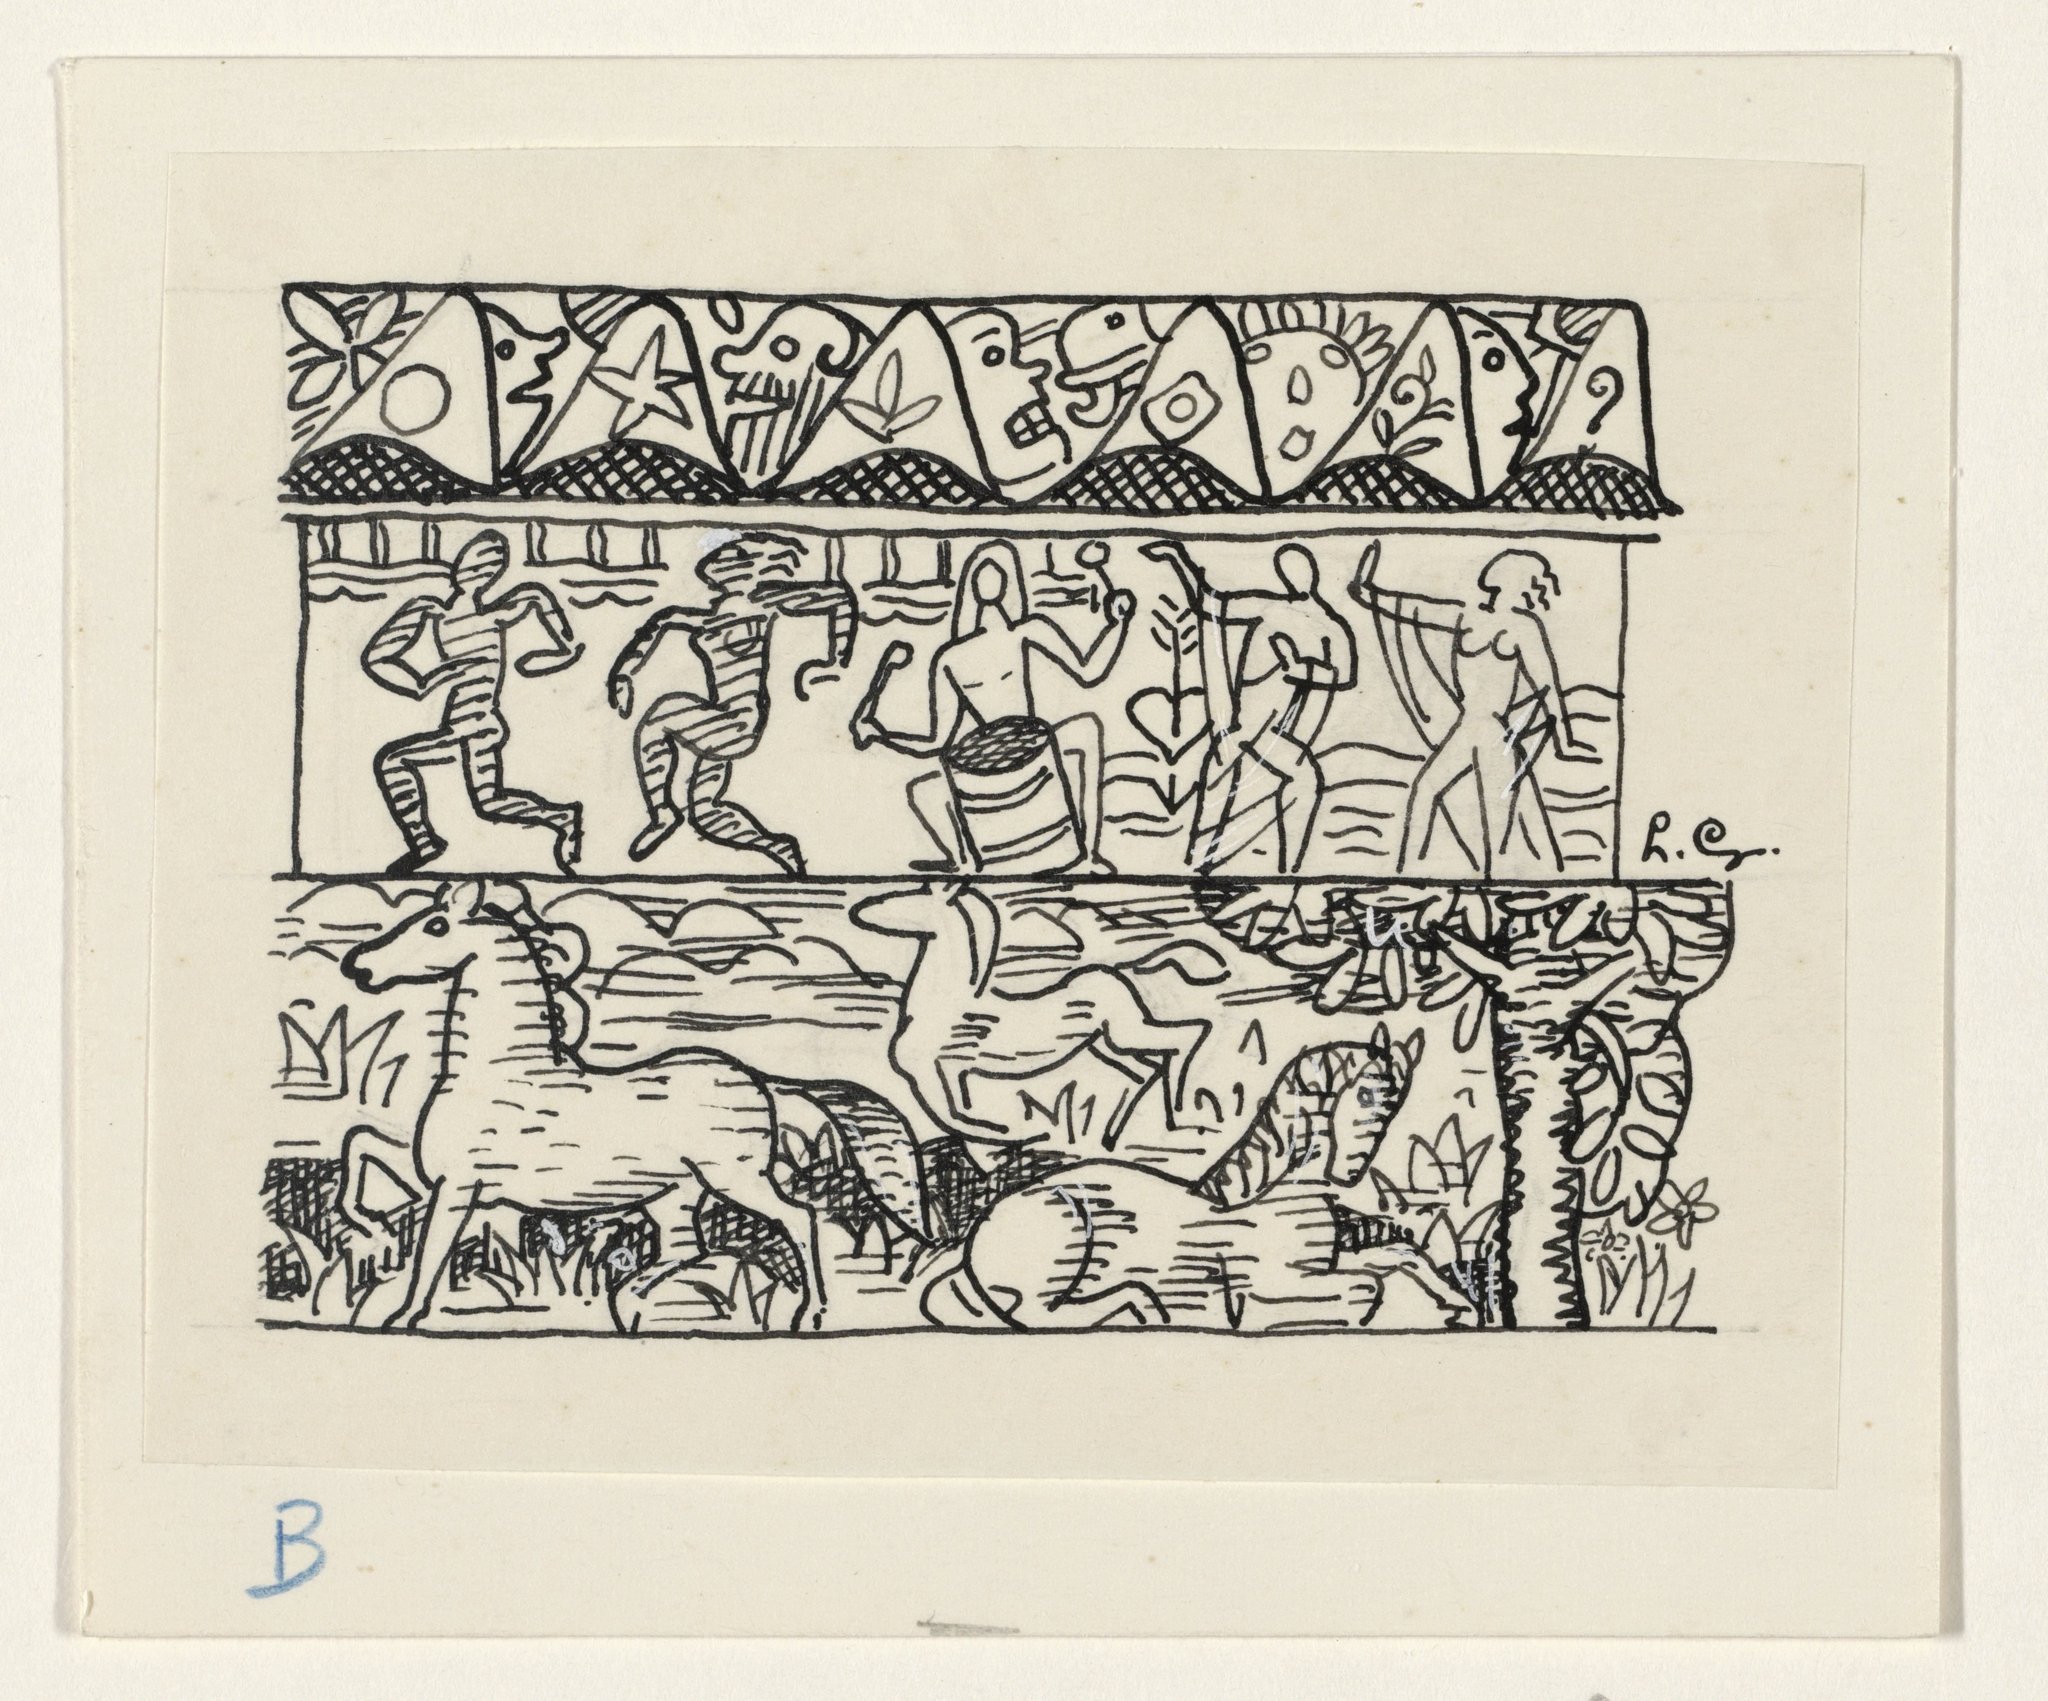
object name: drawing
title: Paarden, dansende mensen en maskers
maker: leo gestel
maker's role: draughtsman, print maker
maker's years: 1881-1941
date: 1891-1941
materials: paint, ink, paper, pencil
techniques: pen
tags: mask, dancing, horse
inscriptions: collector's mark: Lugt 2228